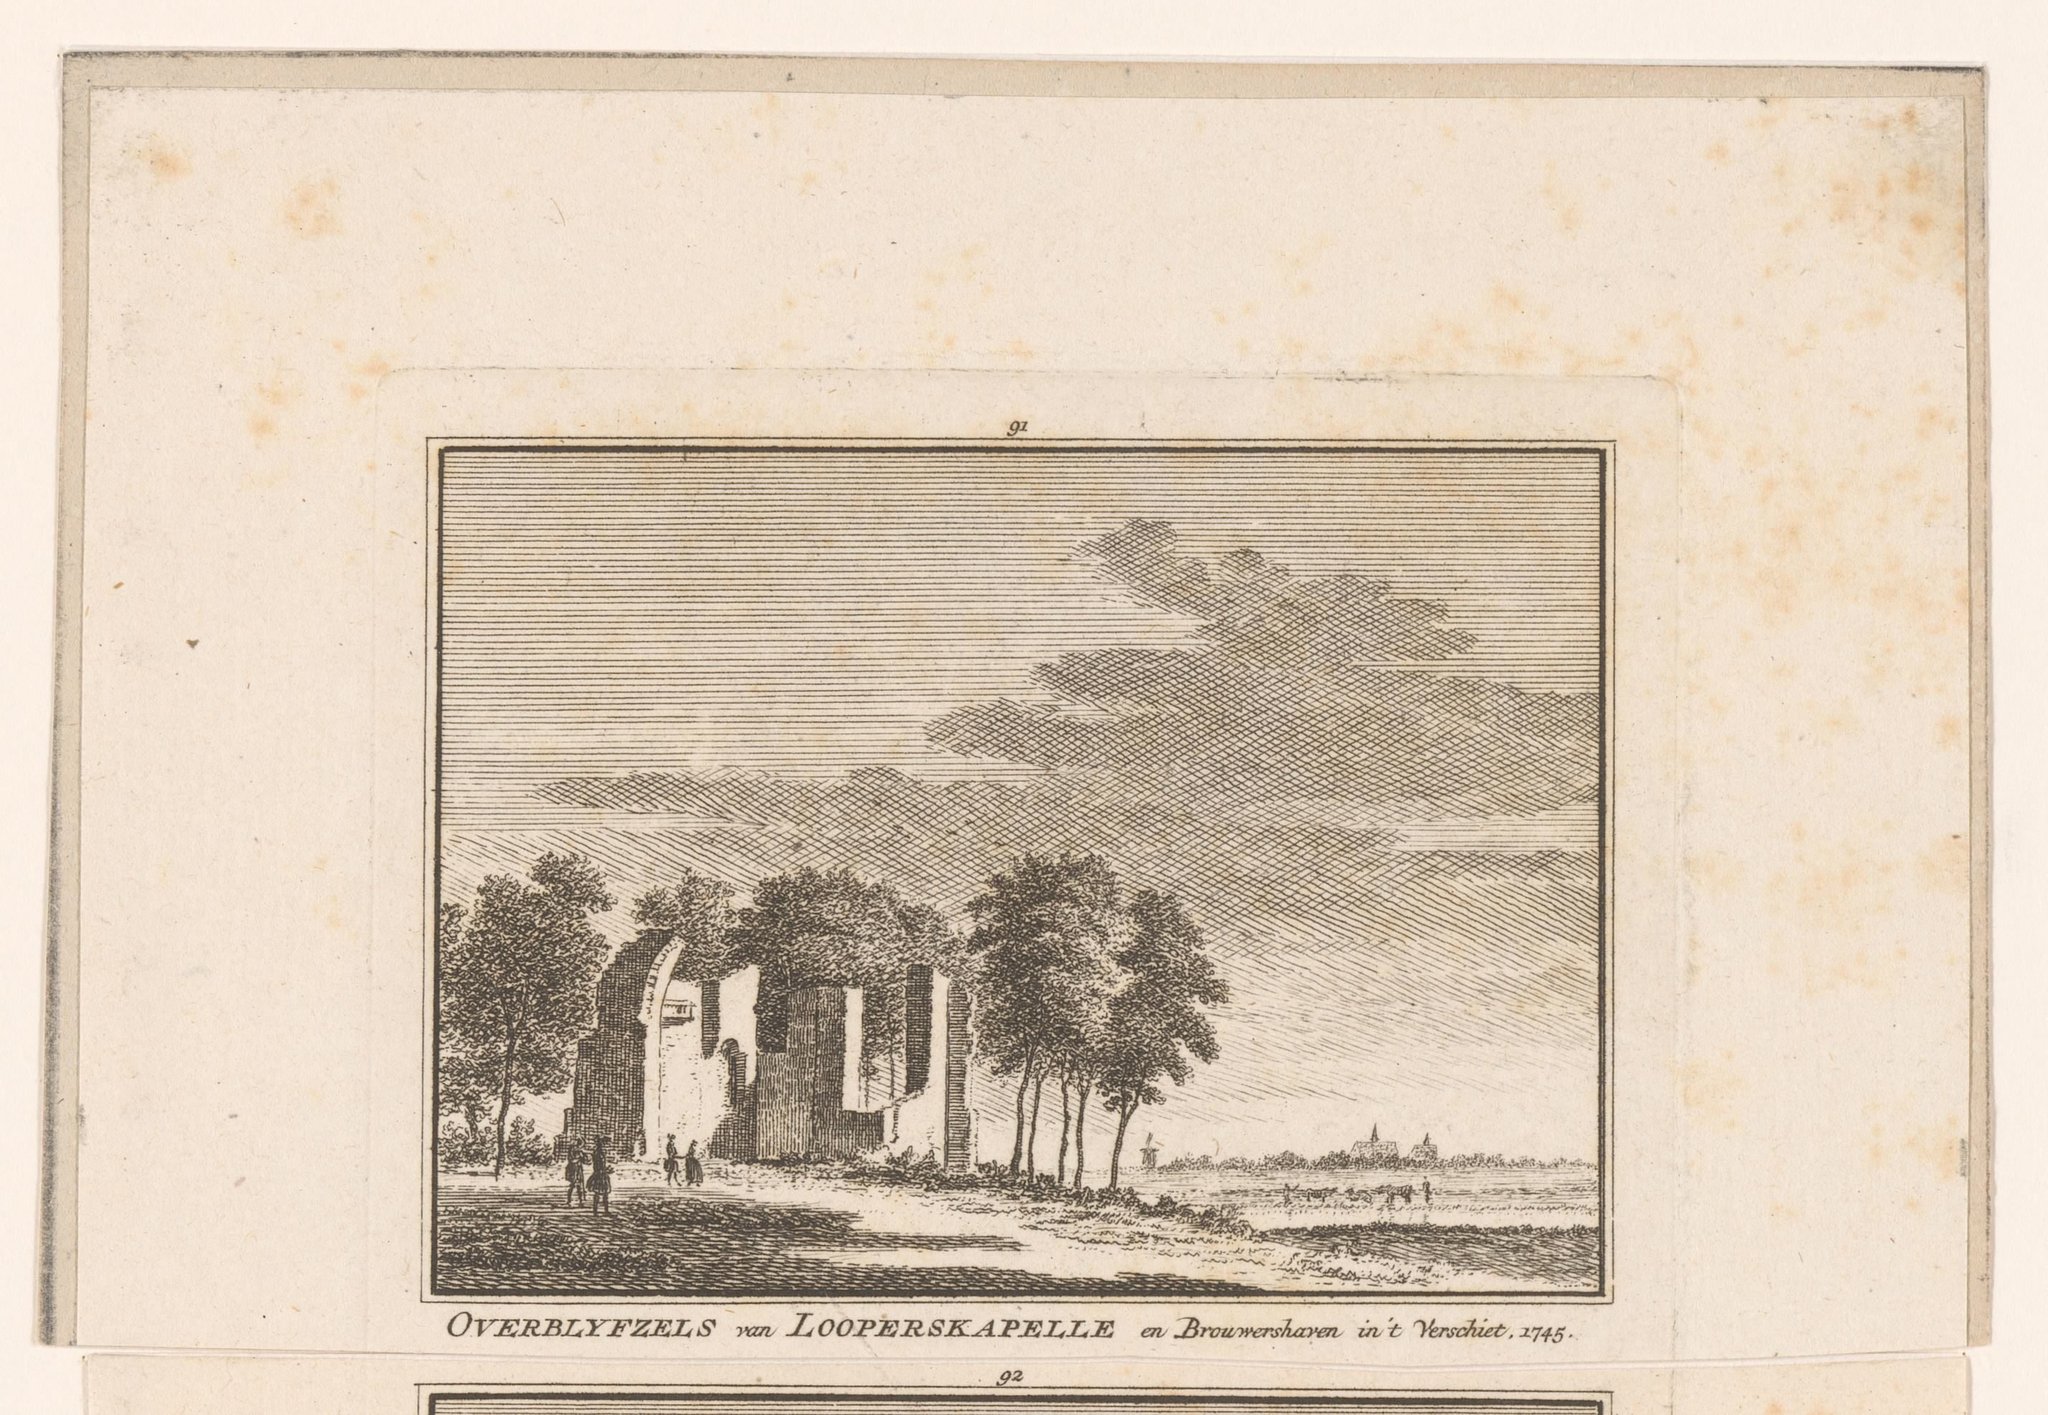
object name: book illustration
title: Het Dorp Nieuwerkerk in Schouwe. 1745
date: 1754-1792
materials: paper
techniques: etching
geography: haarlem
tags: prospect of village, silhouette of village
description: Prent ook gebruikt in: Het verheerlykt Nederland of kabinet van hedendaagsche gezigten van steden, dorpen (…). 9 delen. Amsterdam: Isaak Tirion en weduwe Isaak Tirion, 1745-1774, dl. 5 (1754), ill. 92. Of in: Nederlandsche tafereelen; of eene keurige verzameling van negen honderd fraaije gezigten van steden, dorpen, sloten, oudheden [….]. 9 delen. Amsterdam: Jan de Groot, 1792, dl. 5, ill. 92.